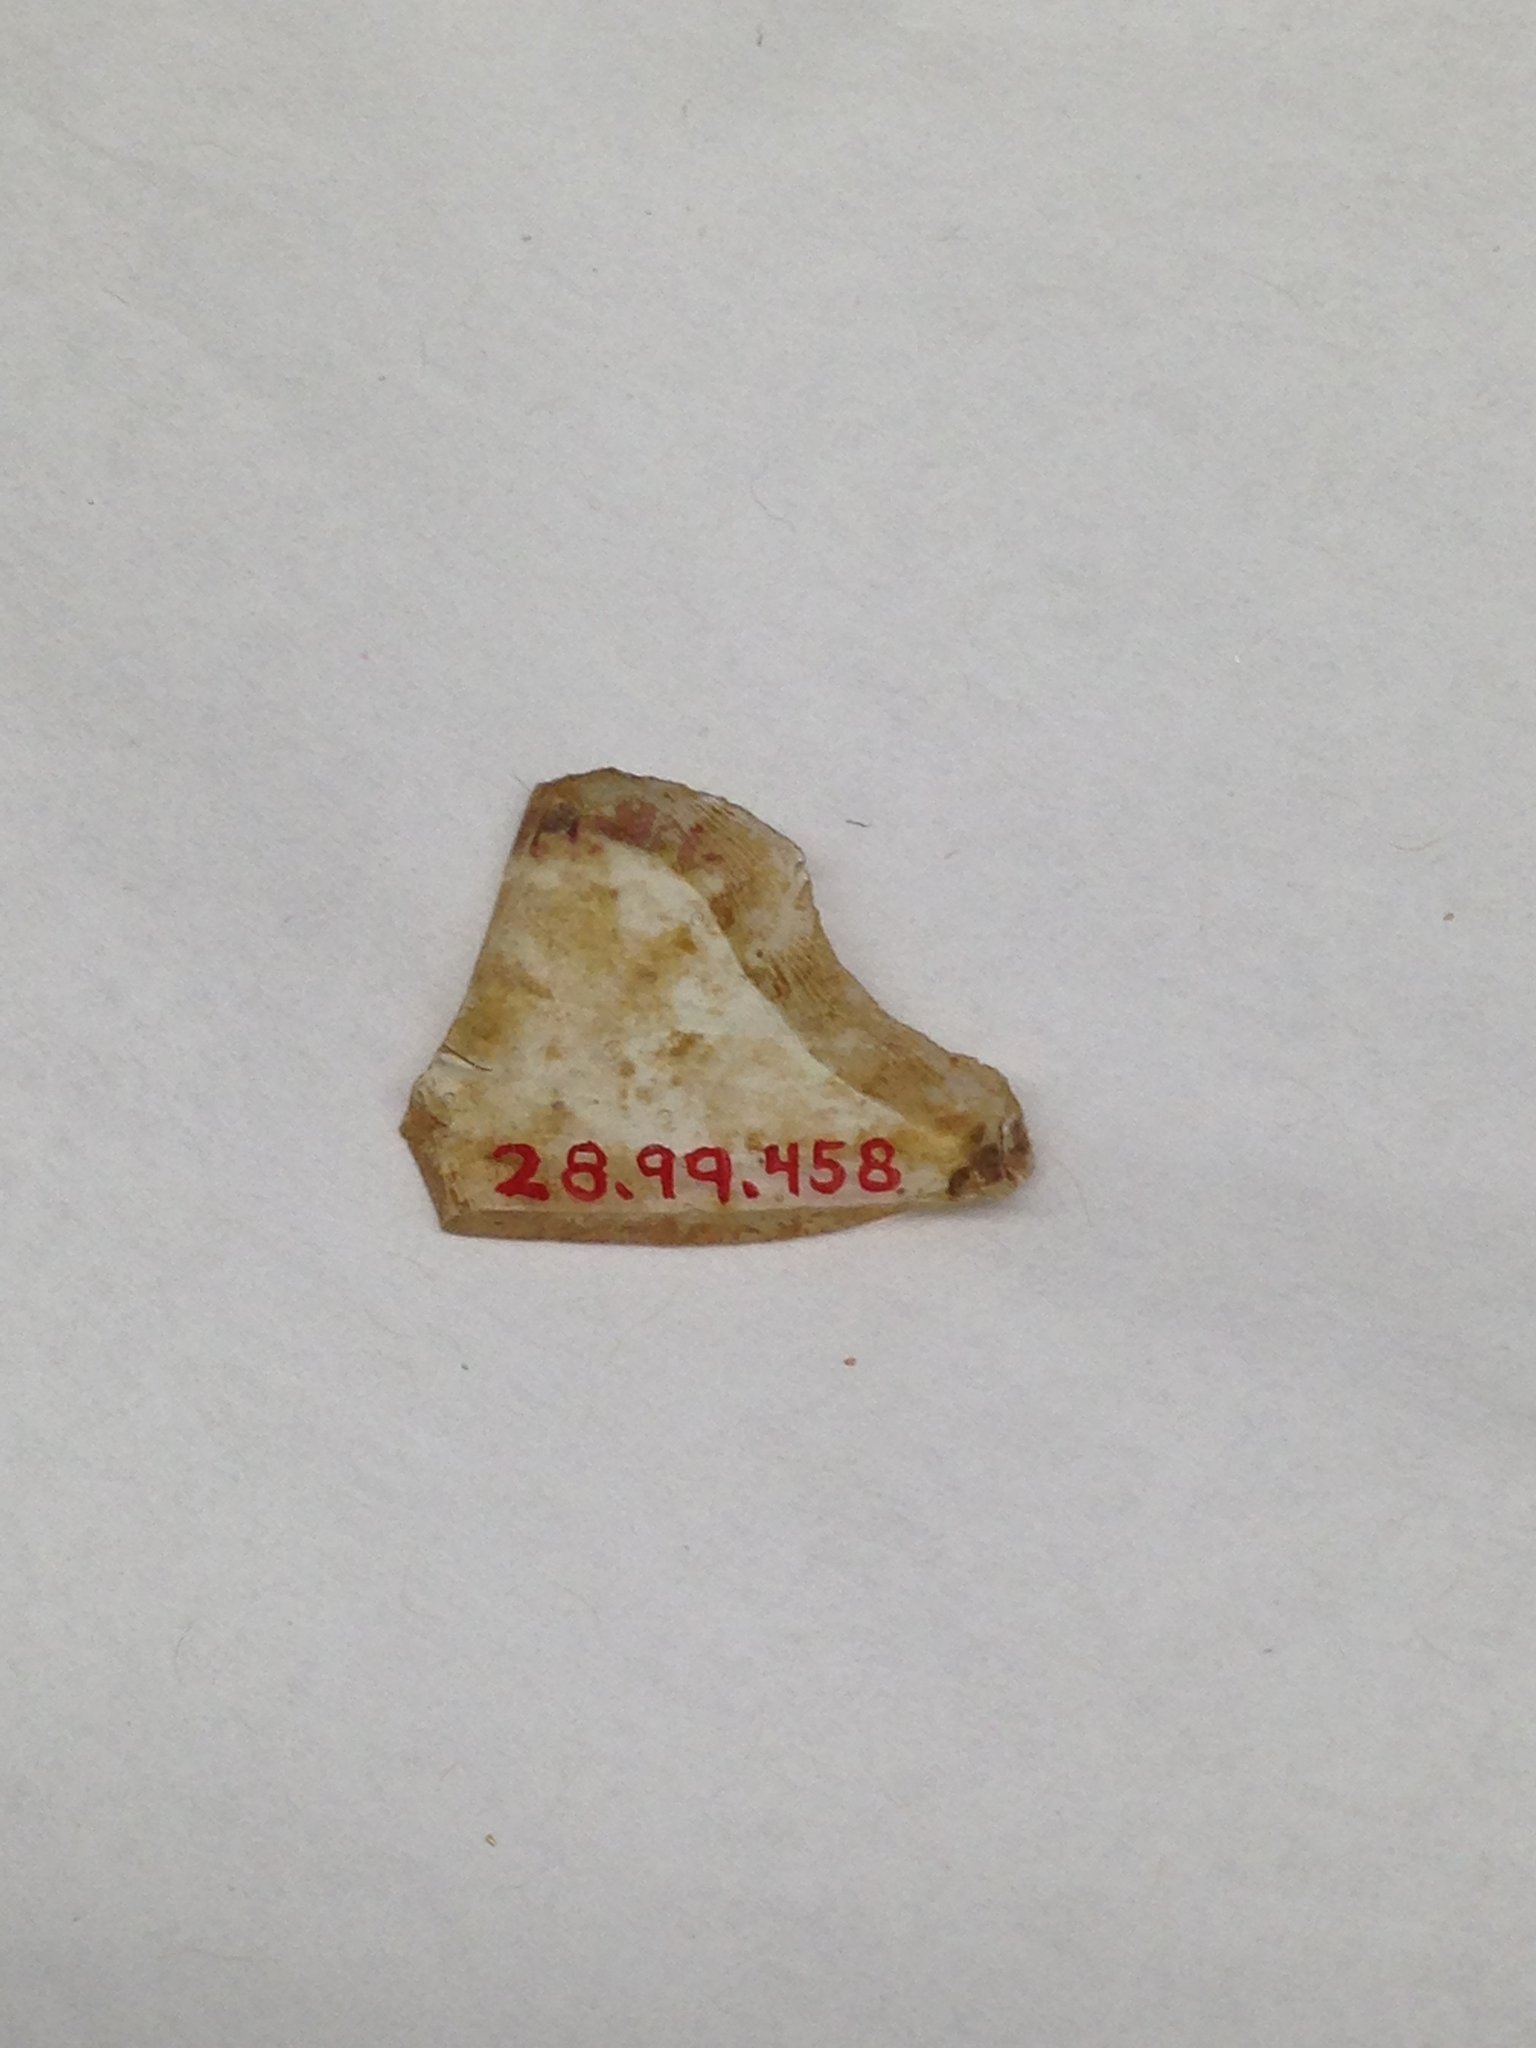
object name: fragment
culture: european or middle eastern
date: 1150-1250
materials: ceramic, glass